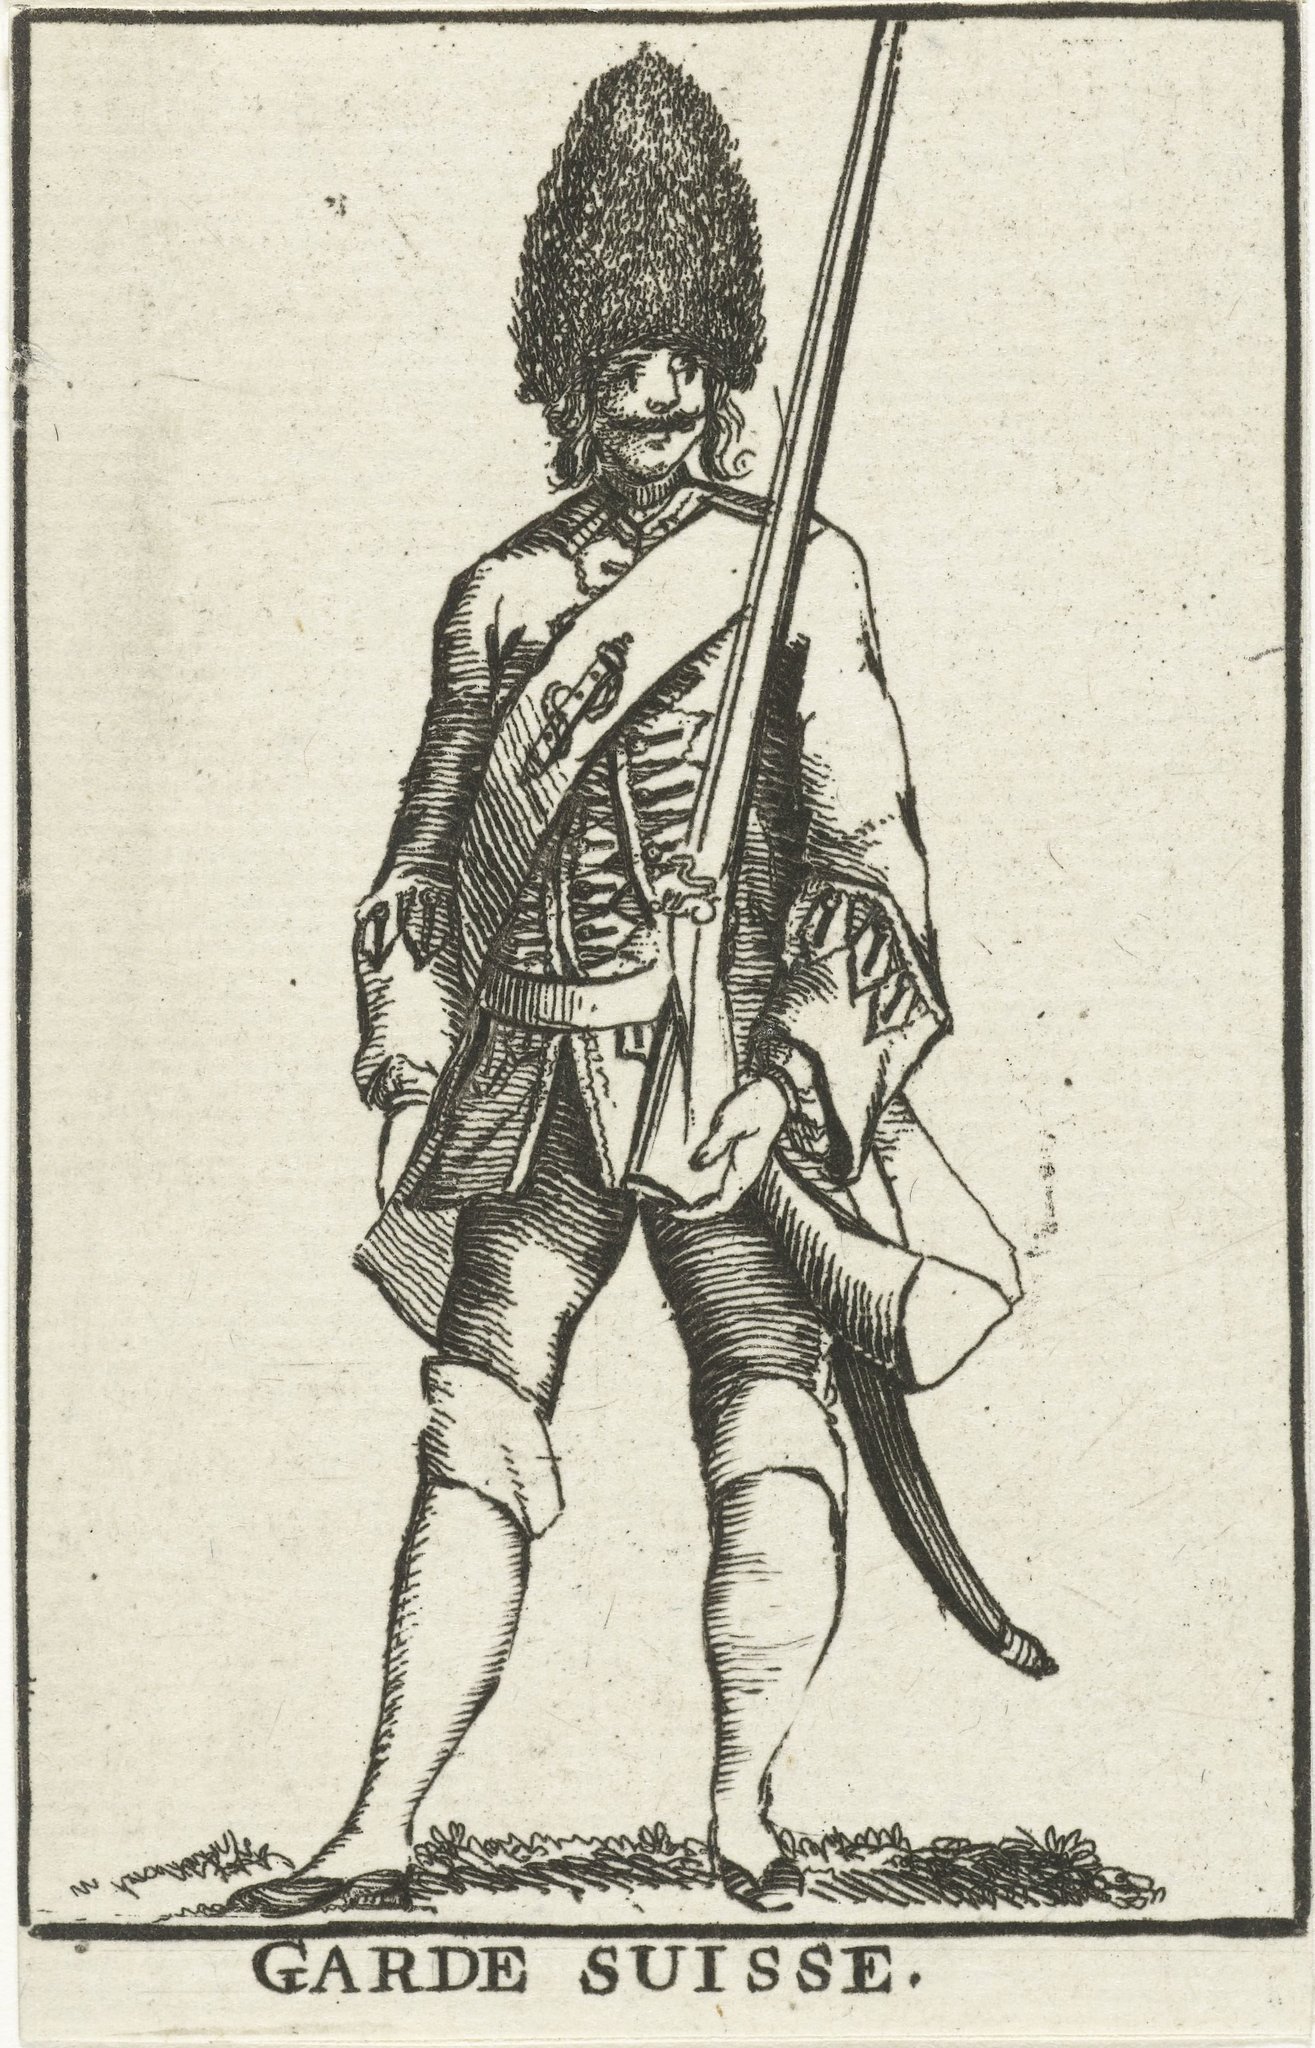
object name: print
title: Zwitserse garde, ca. 1750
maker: Anonymous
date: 1740-1760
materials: paper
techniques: etching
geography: northern netherlands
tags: land forces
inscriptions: collector's mark: Lugt 2228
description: Een lid van de Zwitserse garde, staand met het geweer over de schouder, ca. 1750.